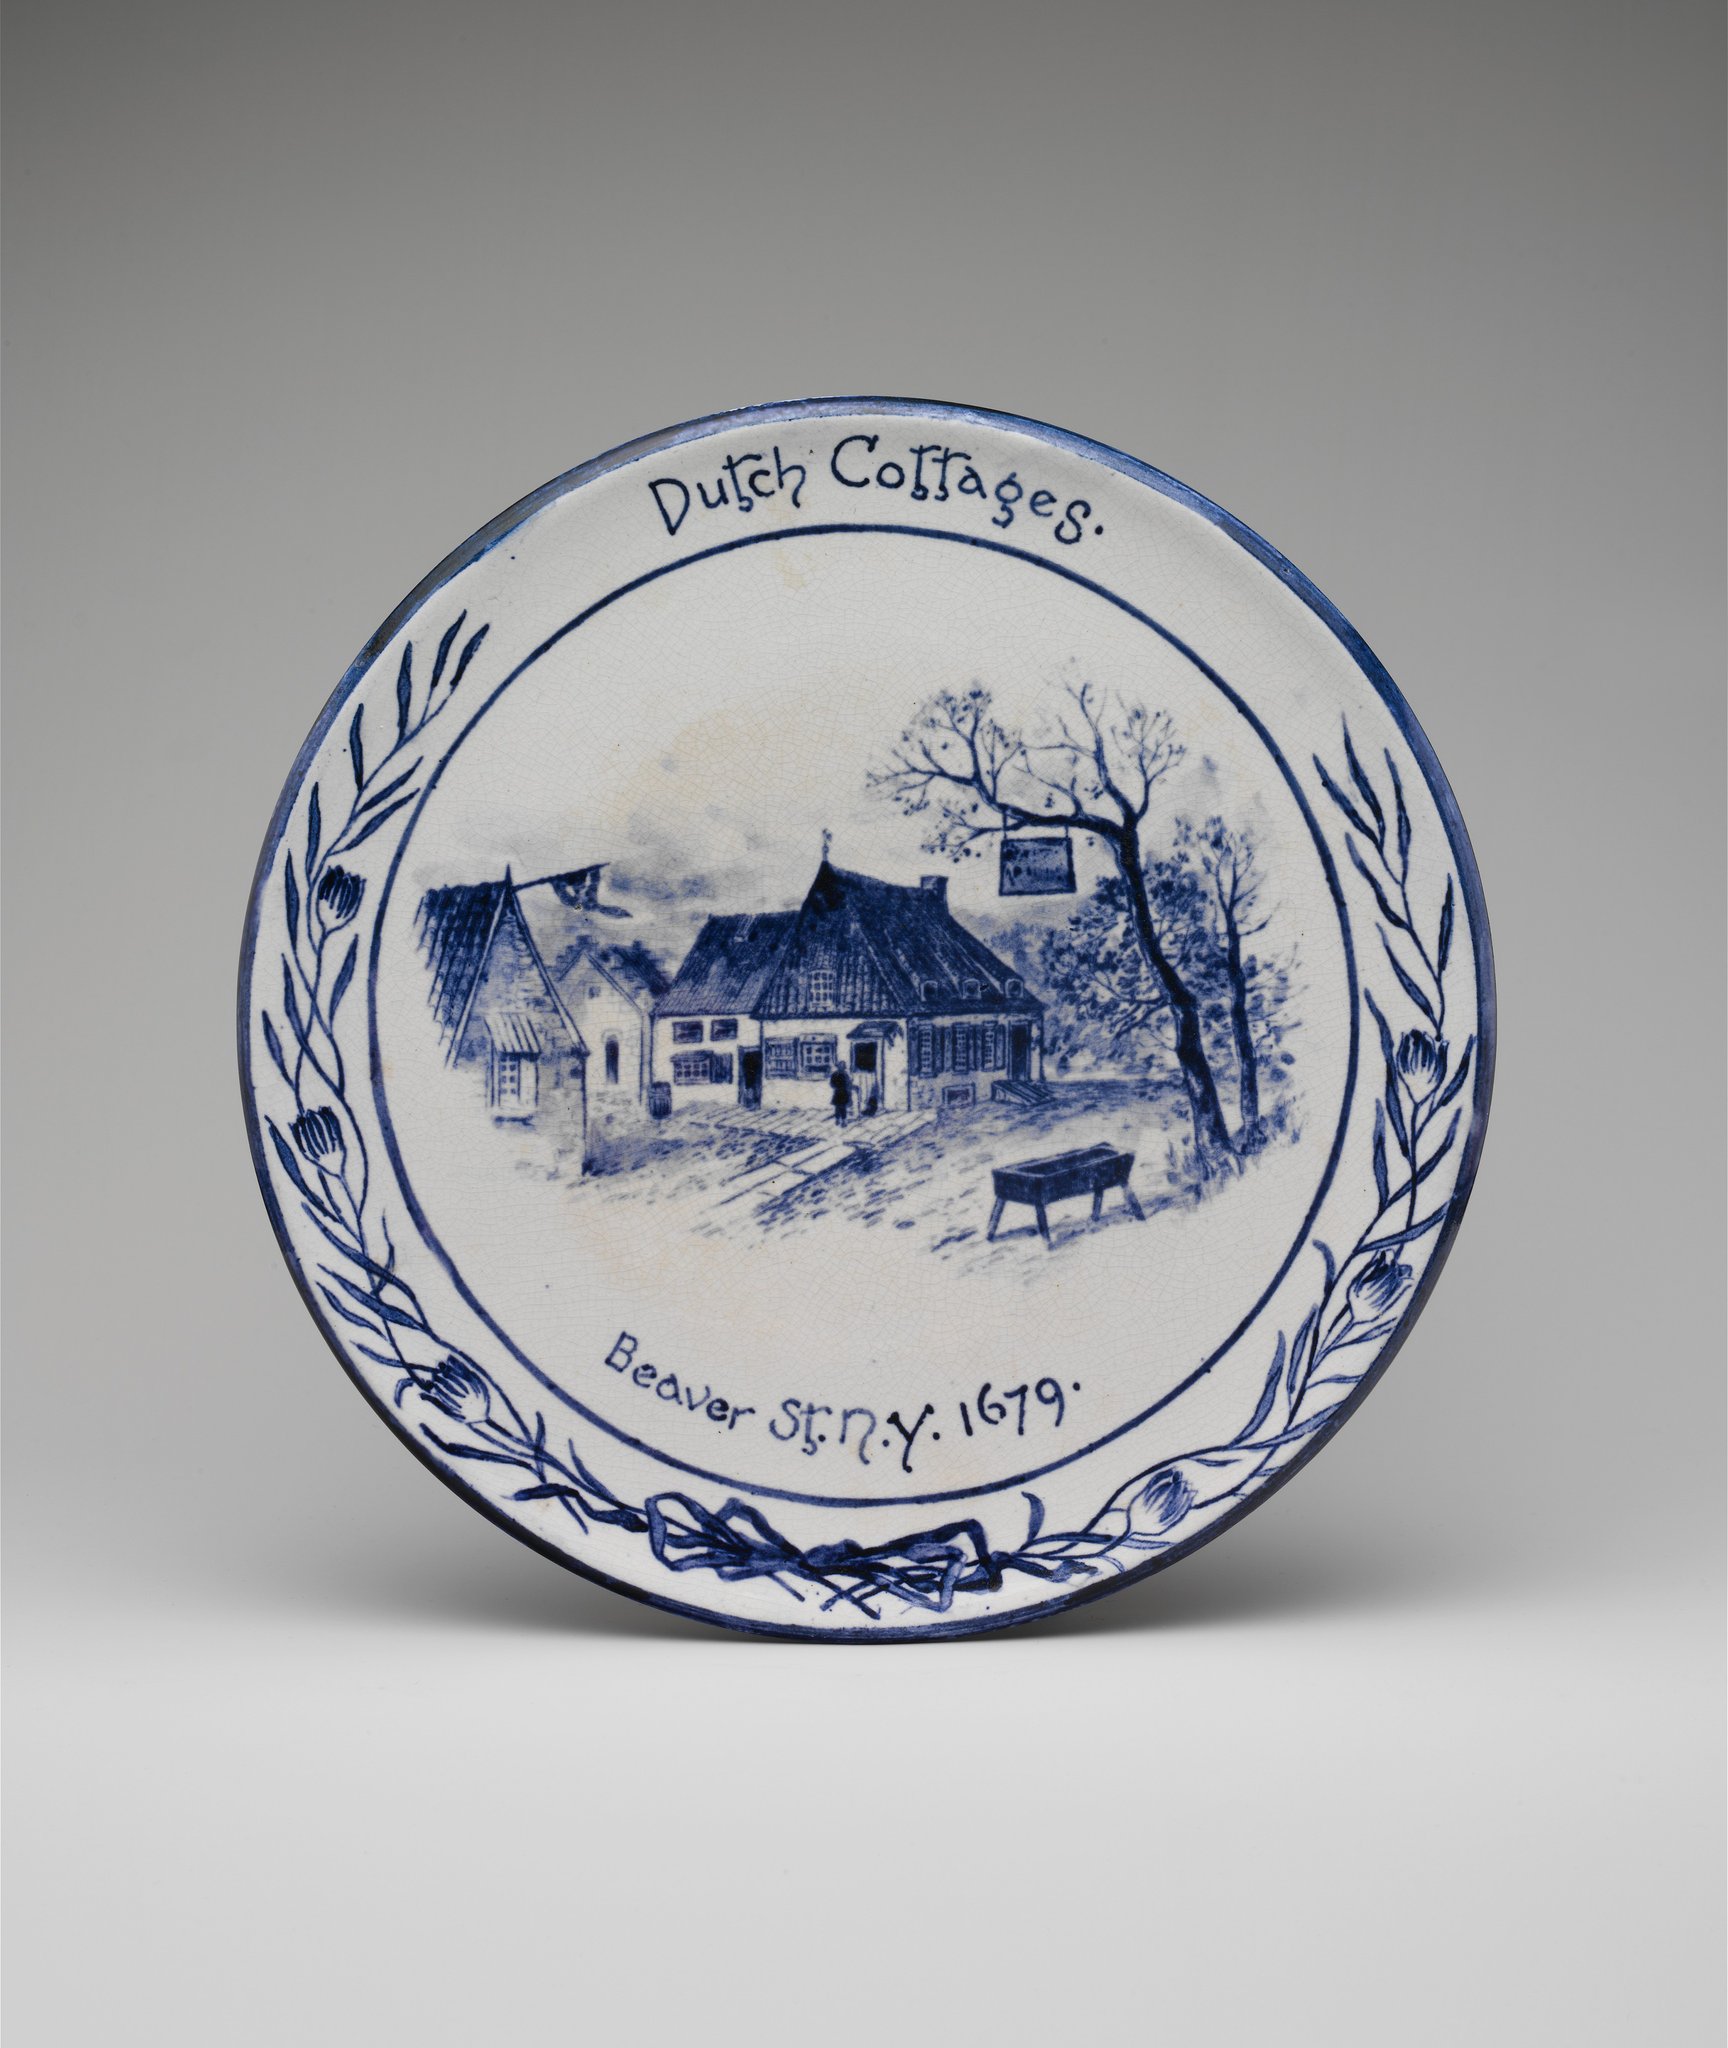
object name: plaque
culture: american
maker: charles volkmar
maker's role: maker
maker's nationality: american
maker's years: 1841-1914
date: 1895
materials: earthenware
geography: united states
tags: houses